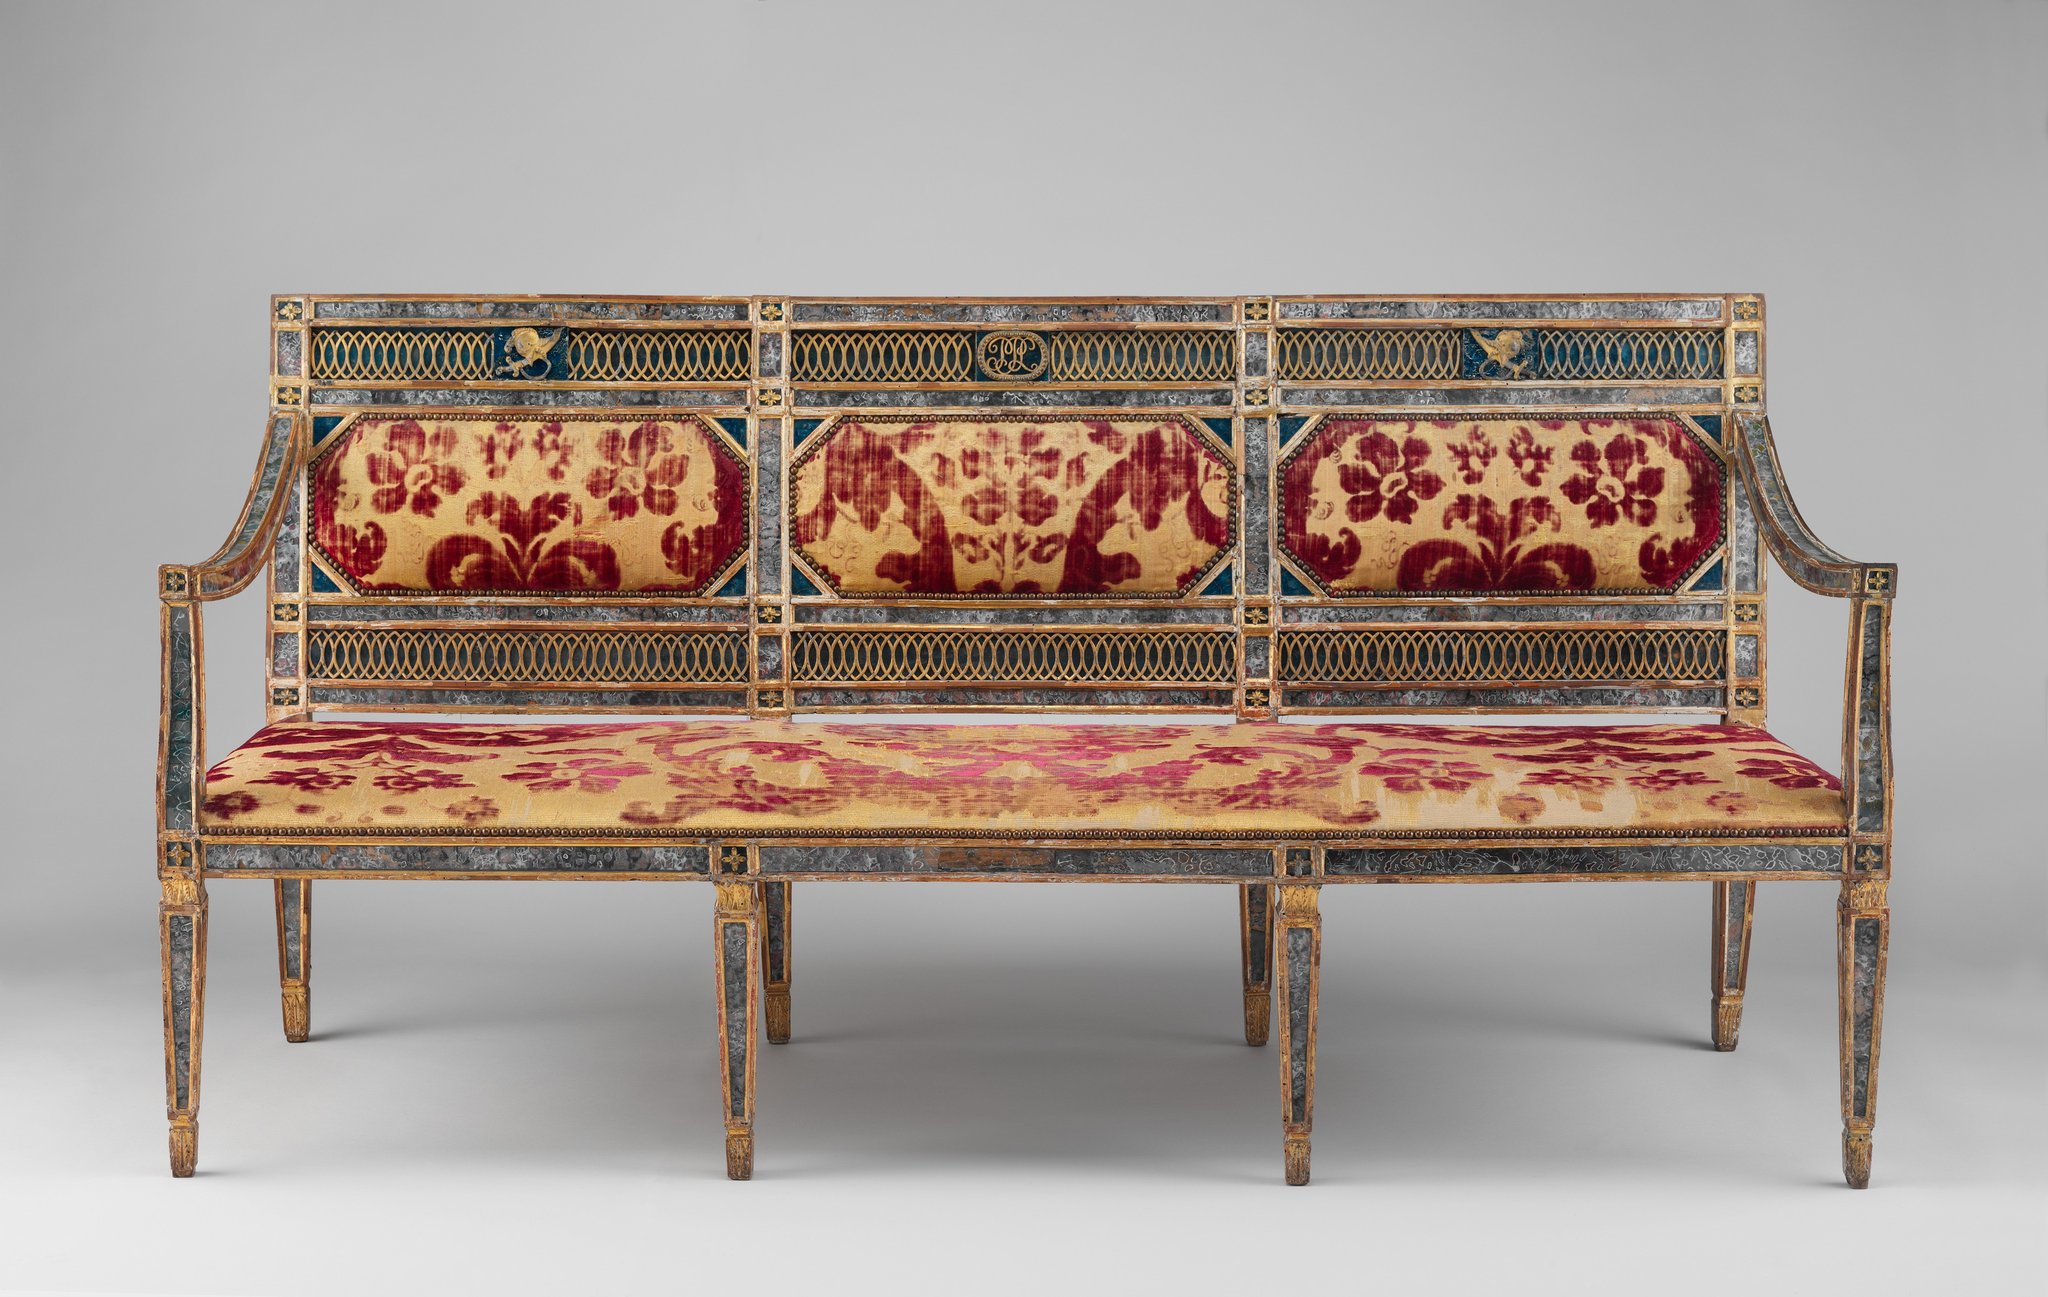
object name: triple back settee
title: Triple-back settee (part of a set)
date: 1790-1800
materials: glass, velvet, wood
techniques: carving, cutting, gilding, painting, voiding